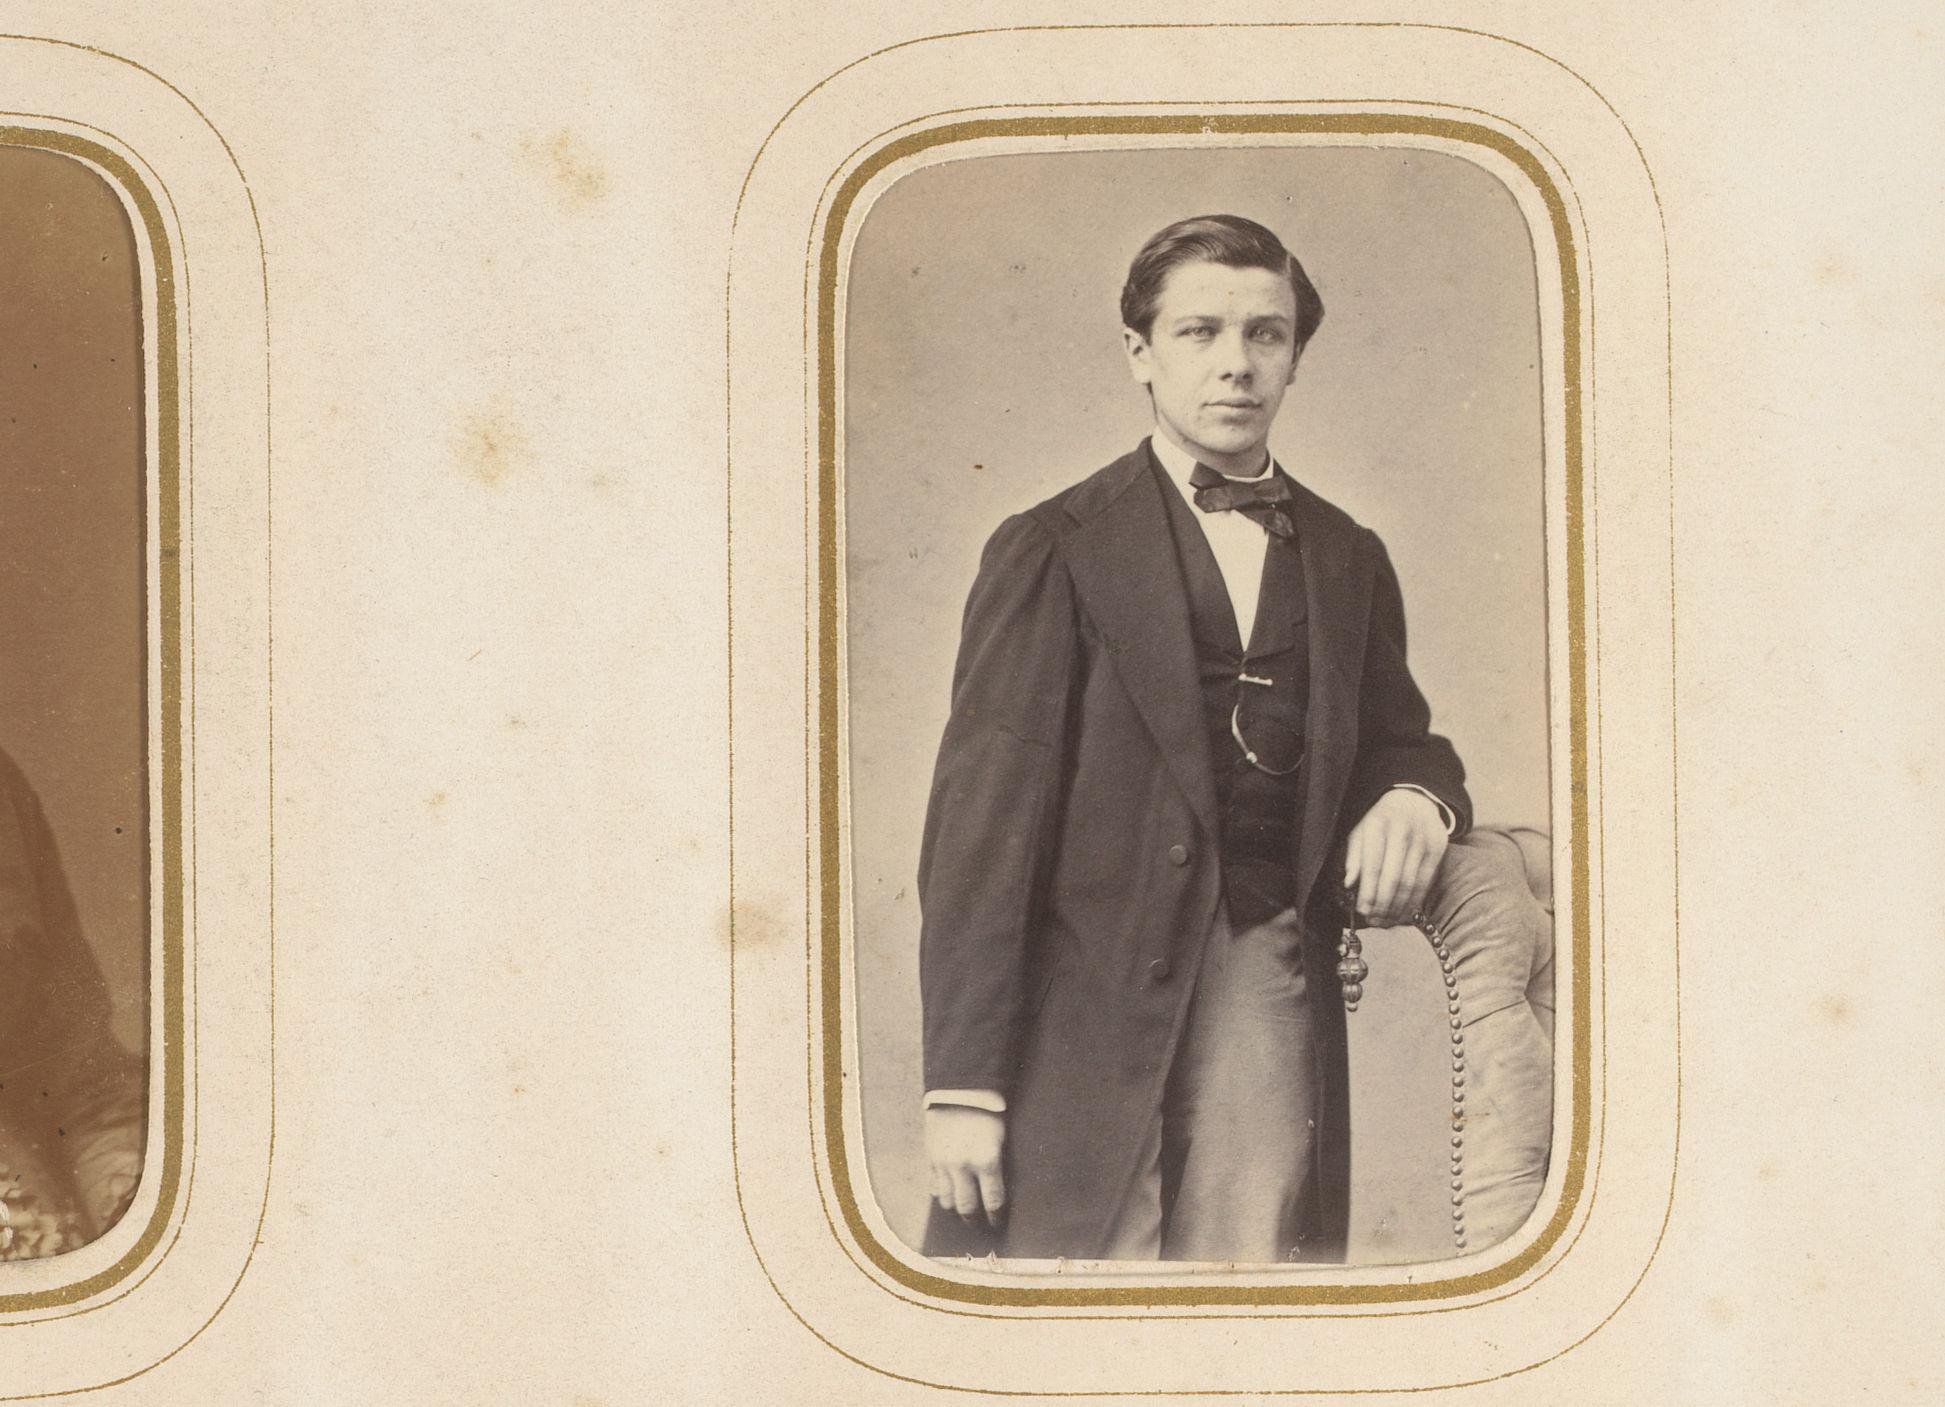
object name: photograph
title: Portret van een jongeman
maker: Anonymous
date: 1860-1890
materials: cardboard, photographic support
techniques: albumen print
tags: historical persons, youth, adolescent